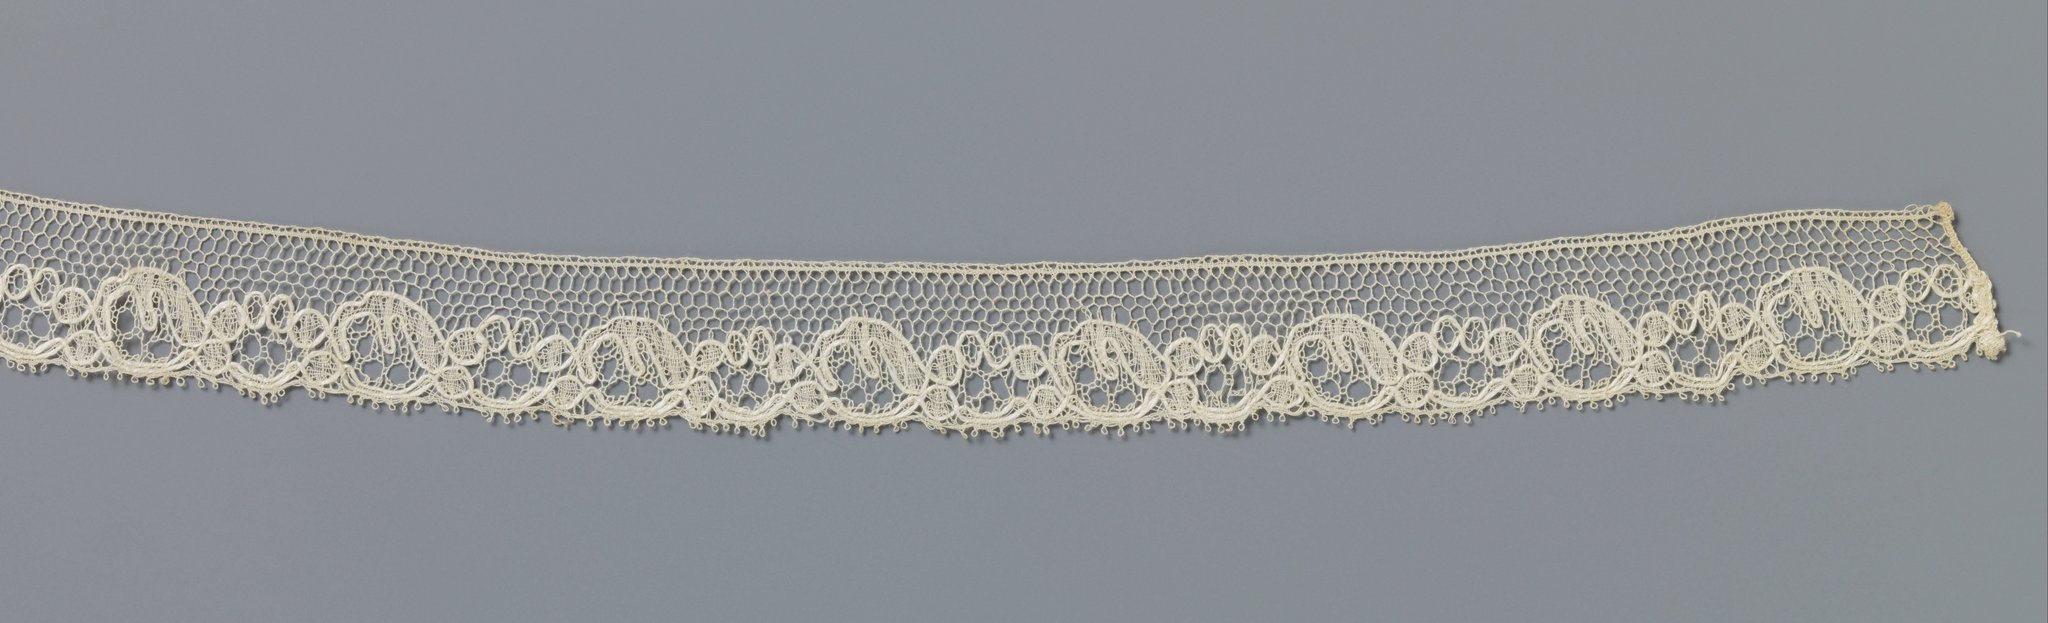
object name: strip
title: Strook kloskant met parelsnoertjes en ovaaltjes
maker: Anonymous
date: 1830-1849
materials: linen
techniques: lace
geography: belgium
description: Strook naturelkleurige kloskant: Rijselse kant. Het zich herhalende patroon langs de onderste helft van de strook bestaat uit een aaneenschakeling van ovaaltjes, afwisselend gevormd door een parelsnoertje en een gestileerd ingesneden blad. De bovenste helft van de strook bestaat uit een fijne traliegrond, een tulegrond. Het spaarzame volwerk is gemaakt in linnenslag, met dikkere en glimmende contourdraden. In de ovaaltjes is één soort siergrond toegepast die cirkeltjes vormt, zogenaamde 'punaises'. Boven- en onderzijde zijn recht afgewerkt, waarbij de onderzijde is voorzien van picots.